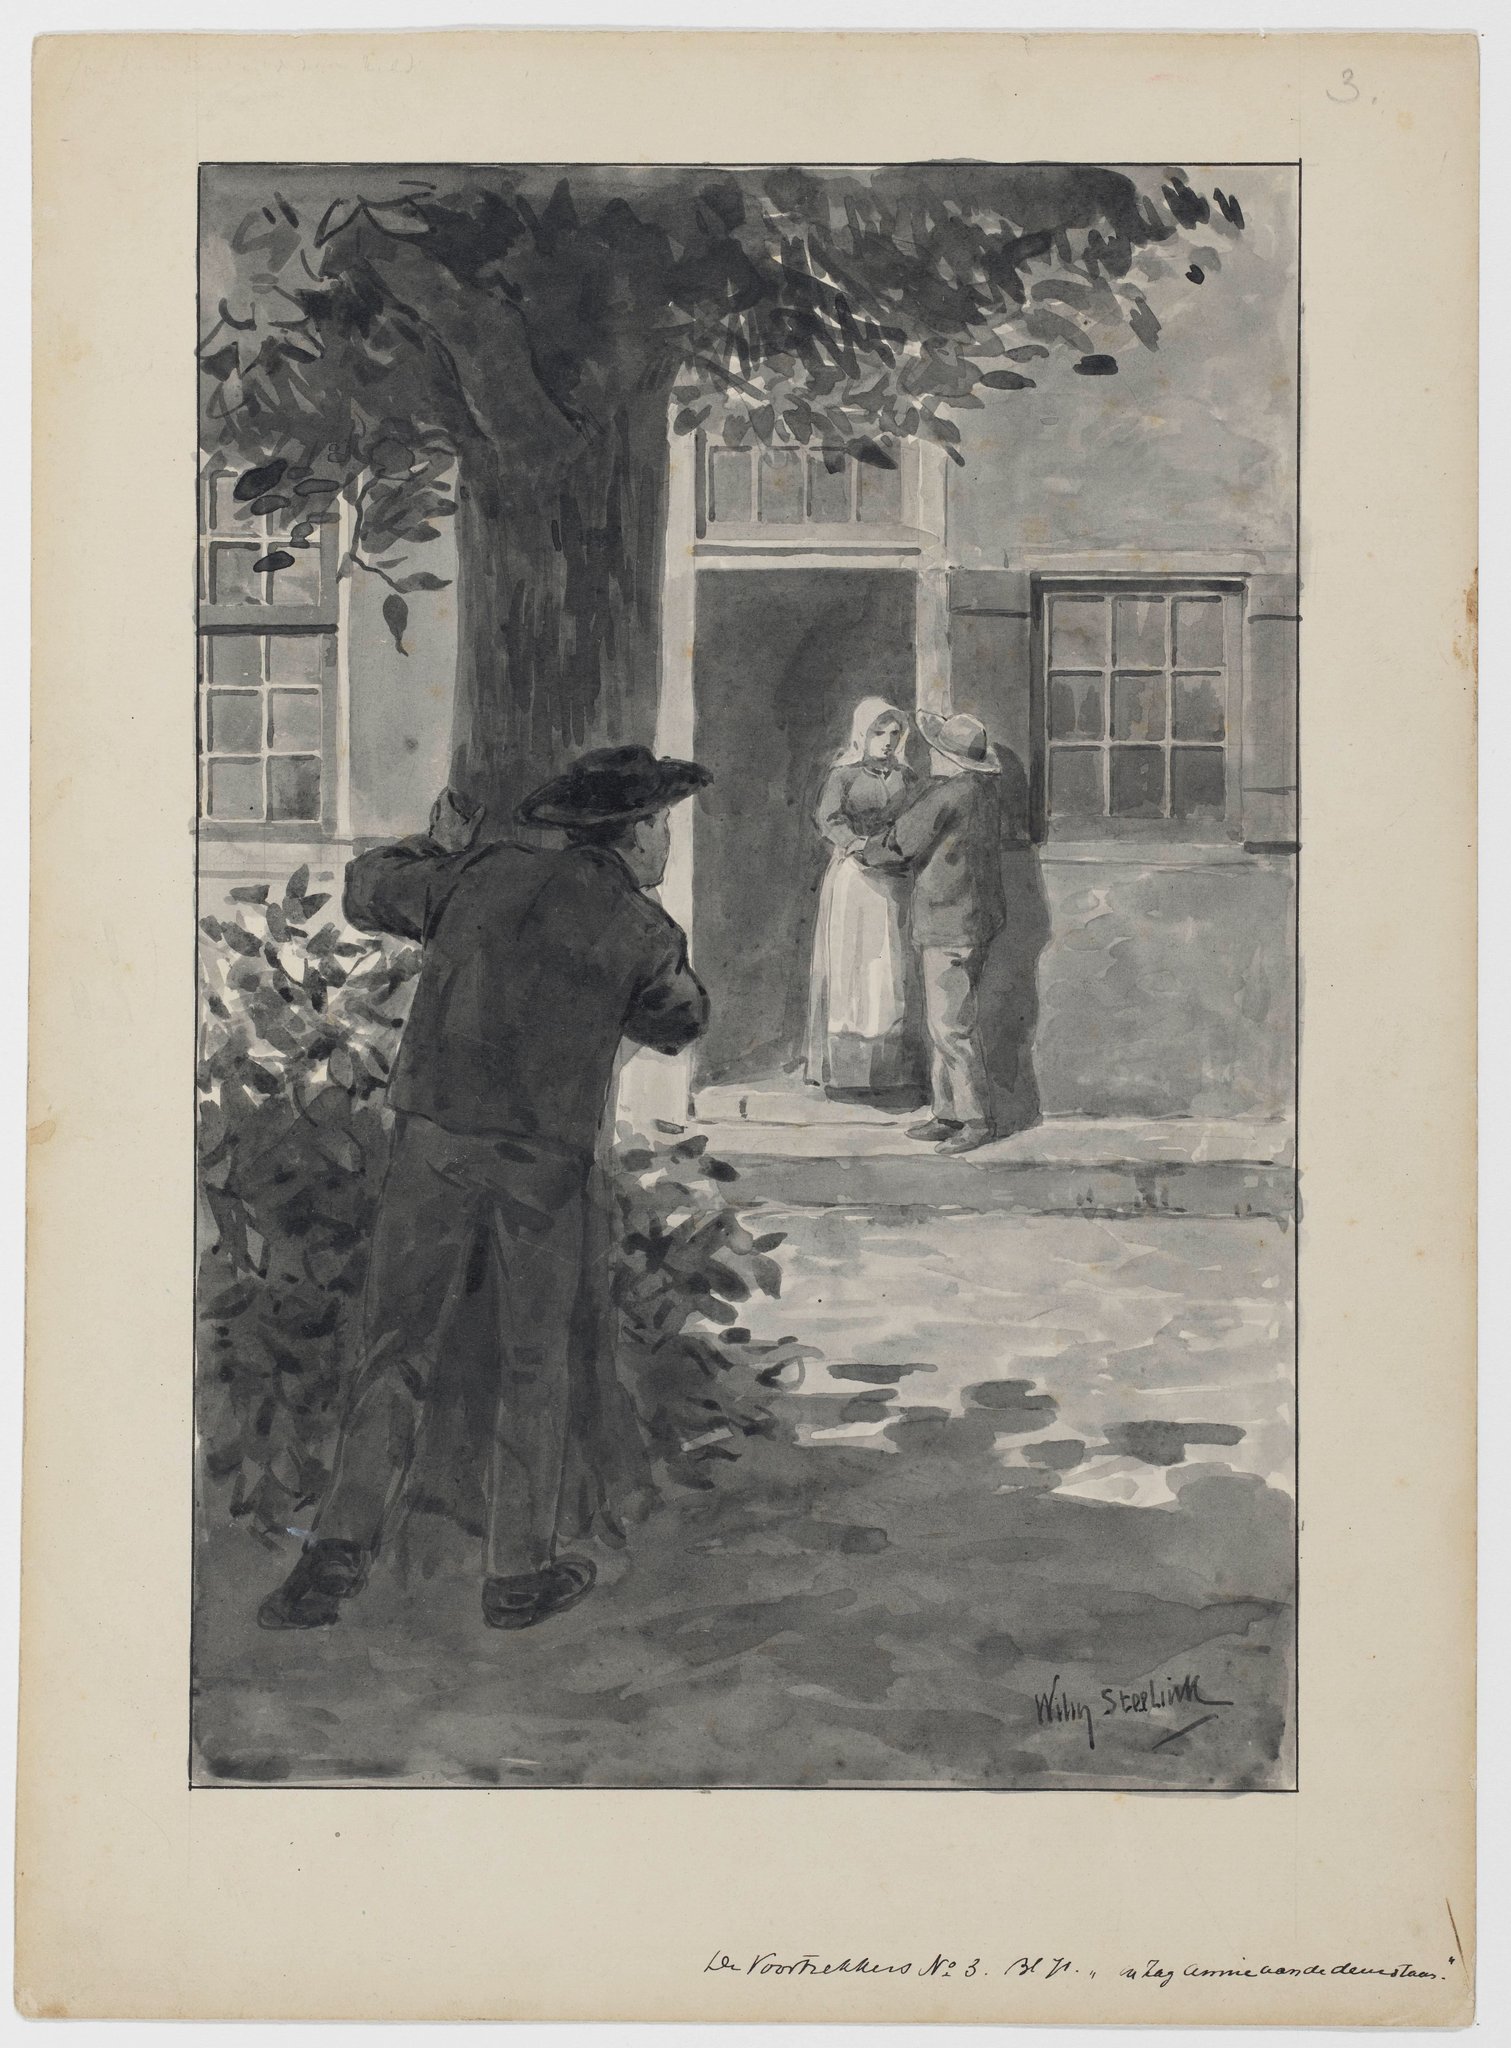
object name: design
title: Ik zag Annie aan de deur staan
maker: willem steelink (i)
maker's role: draughtsman, print maker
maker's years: 1826-1913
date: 1836-1913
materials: paper, pencil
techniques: brush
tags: illustration ~ printed matter, book, street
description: Ontwerp voor een illustratie in De Voortrekkers, of Het Dagboek van Izak van der Merwe, door J.D. Kestell en N. Hofmeijer.